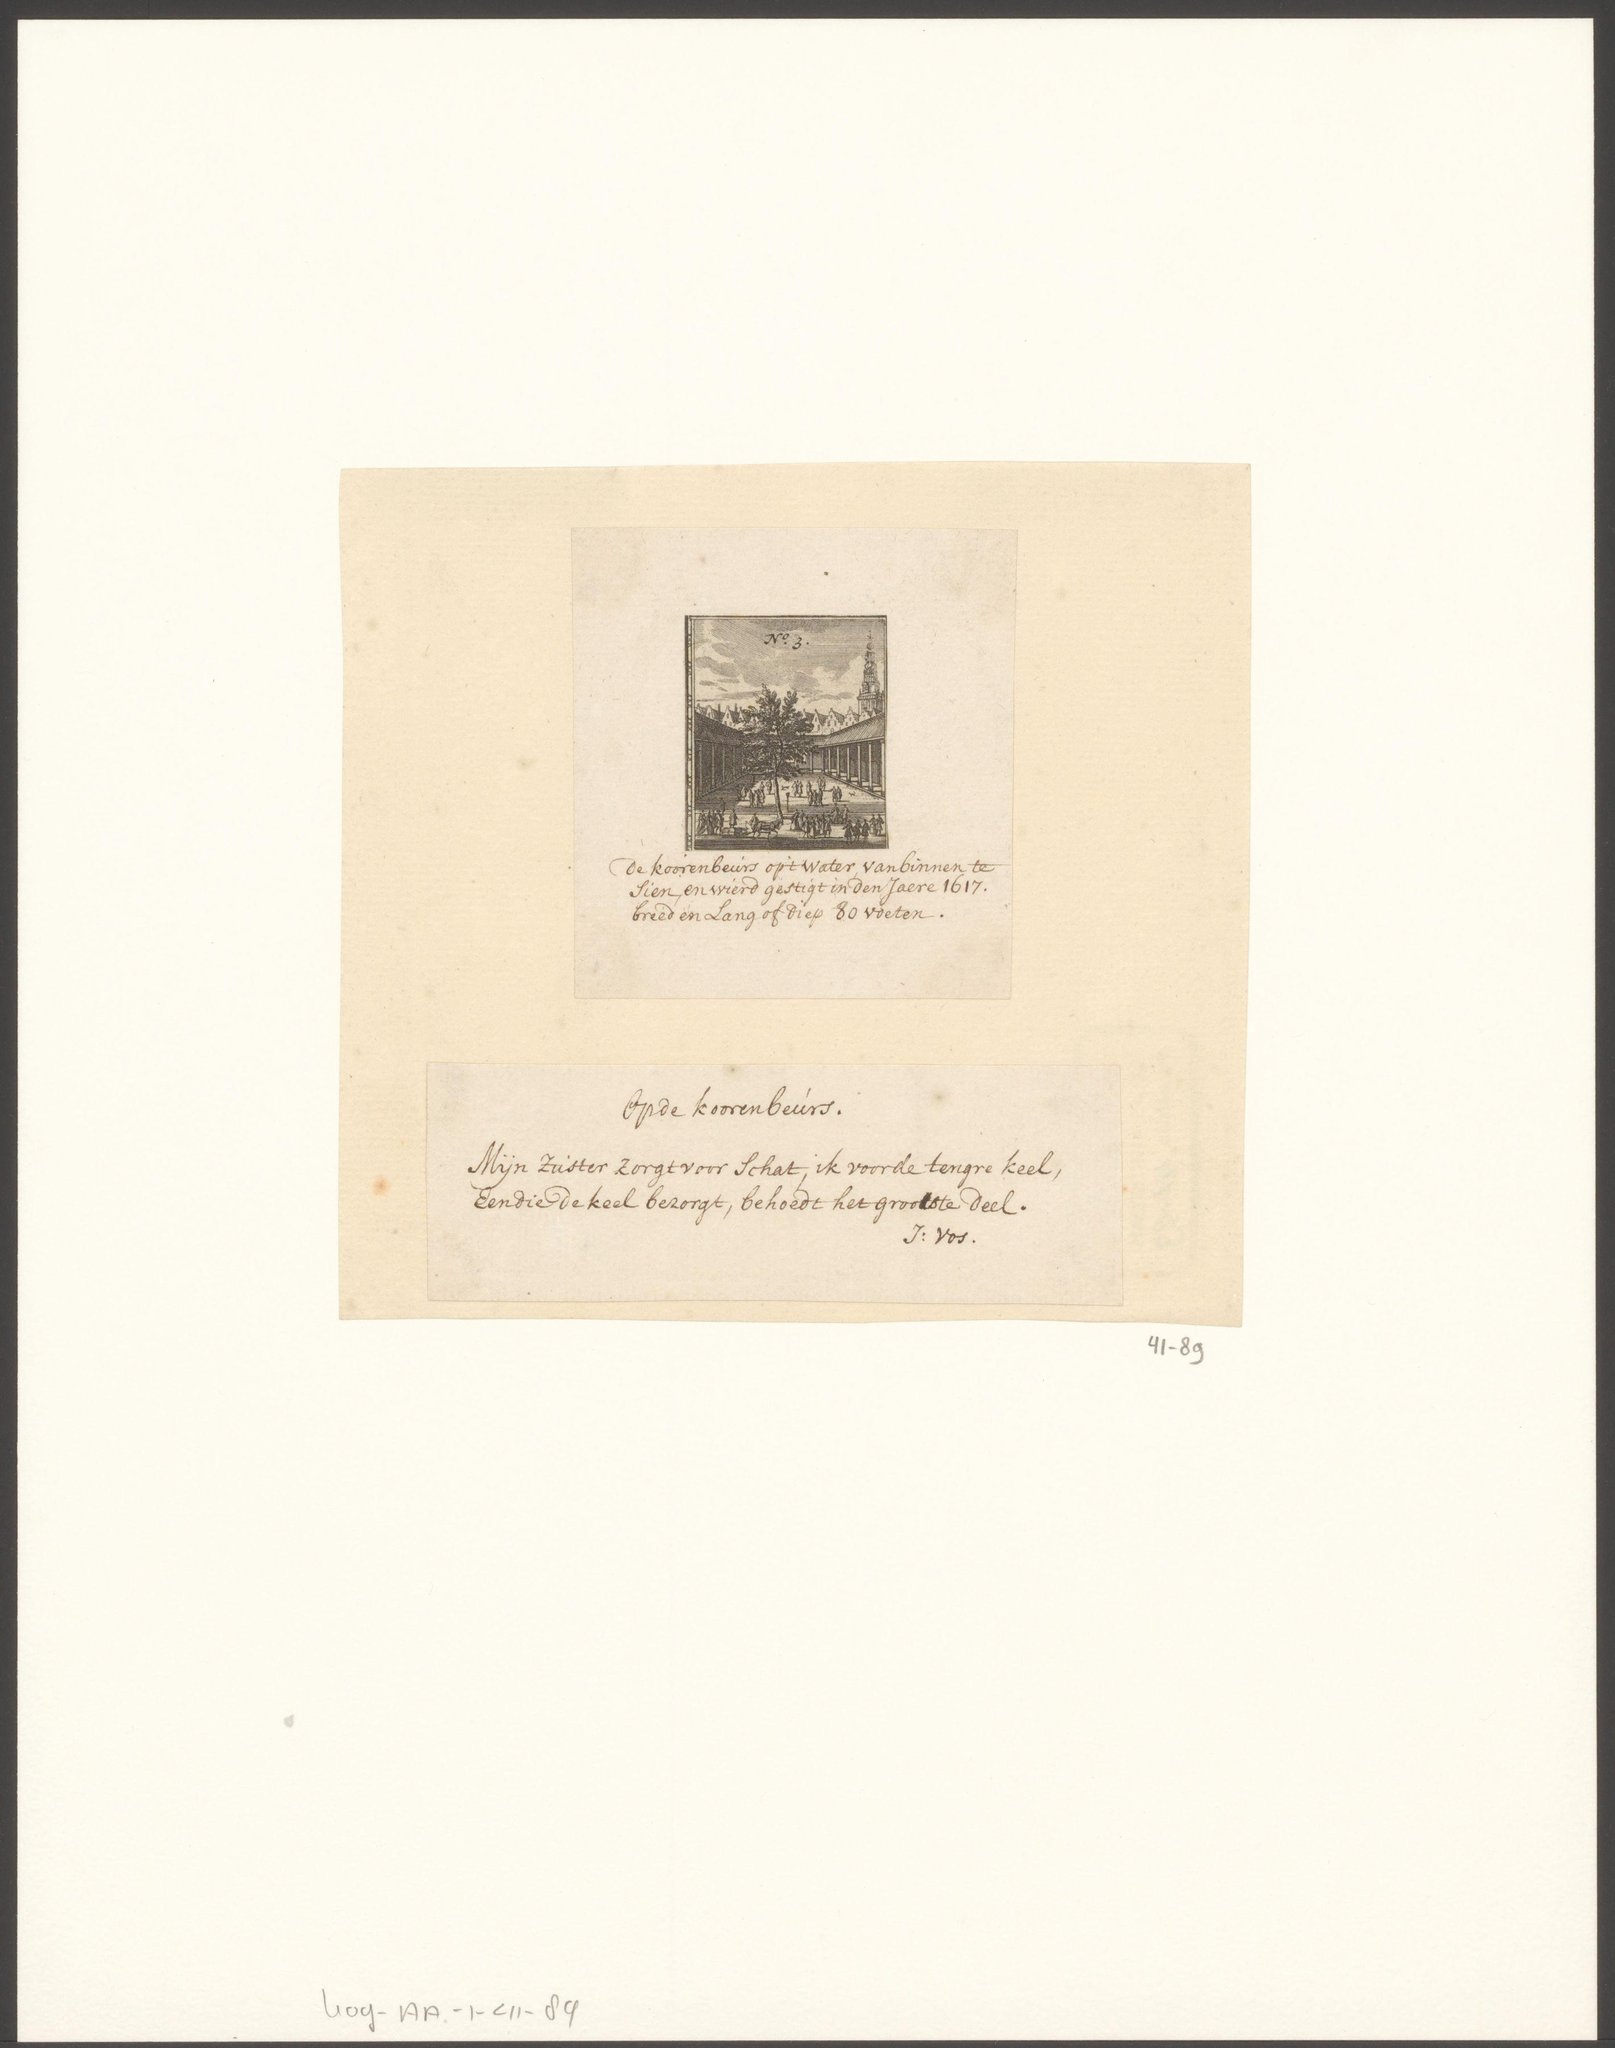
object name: print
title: Gezicht op de Korenbeurs te Amsterdam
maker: Anonymous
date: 1700-1799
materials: ink, paper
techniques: etching, pen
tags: market-hall, parts of church exterior and annexes: tower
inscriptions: inscription: ‘Op de koorenbeurs. / Mijn zuster zorgt voor schat, ik voor de tengre keel, / Een die de keel bezorgt, behoedt het grootste deel. / J: Vos.’, collector's mark: ‘41-89’ Lugt 1641b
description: Boven genummerd: No. 3. Eronder een handgeschreven tekst opgeplakt met: Op de koorenbeurs. / Mijn zuster zorgt voor schat, ik voor de tengre keel, Een die de keel bezorgt, behoedt het grootste deel. / J: Vos. Onderwerpsrubriek binnen de Atlas Amsterdam: Korenbeurs.